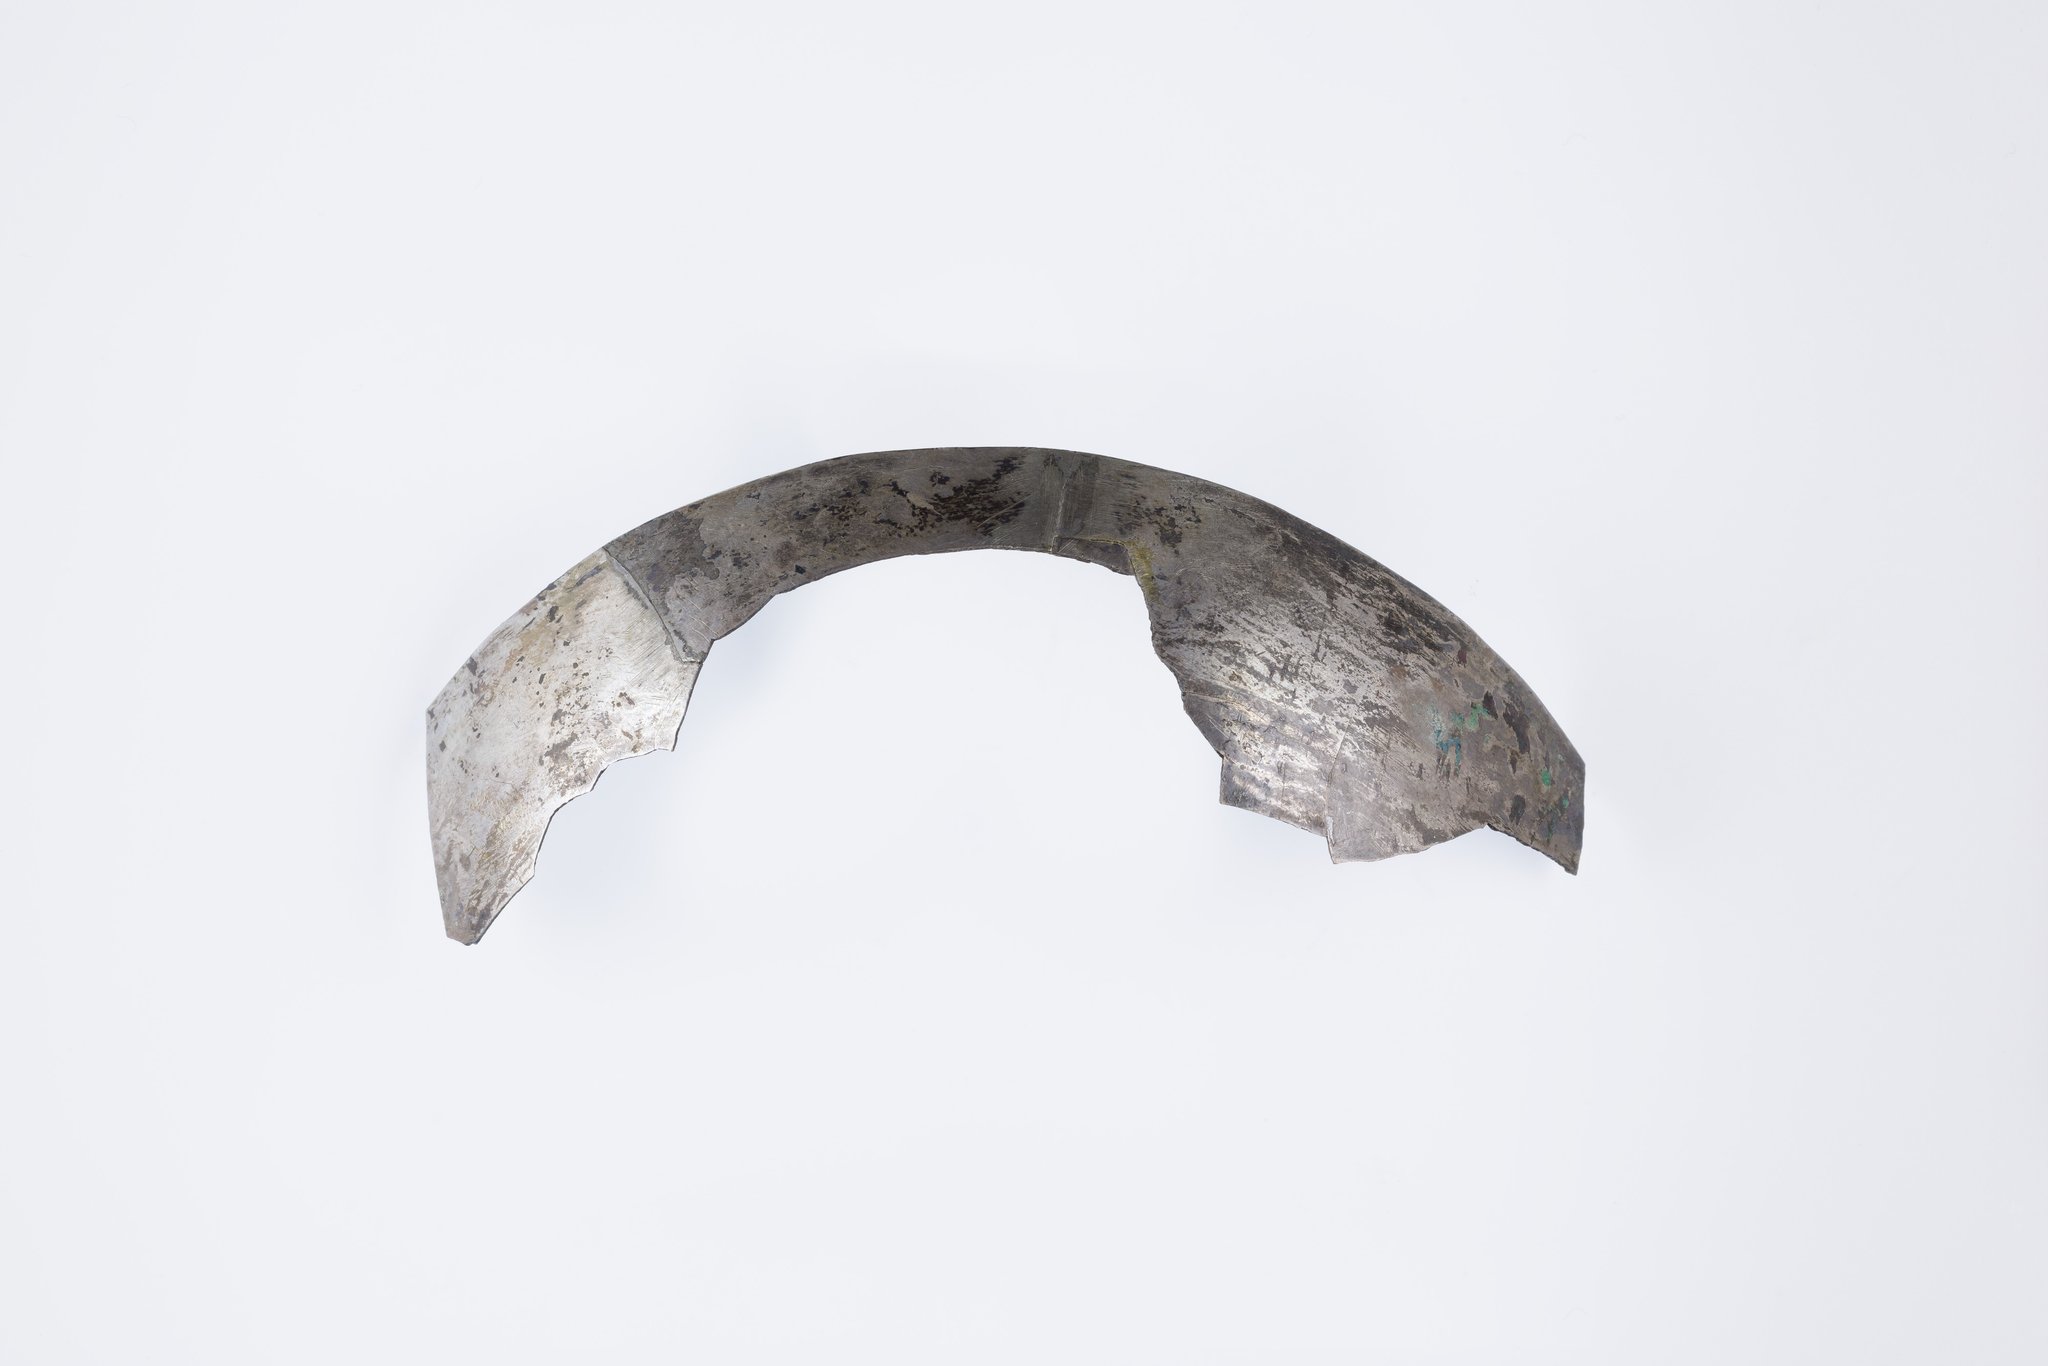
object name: fragment of a bowl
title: Bowl fragment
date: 1295-1070 BCE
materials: silver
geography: egypt